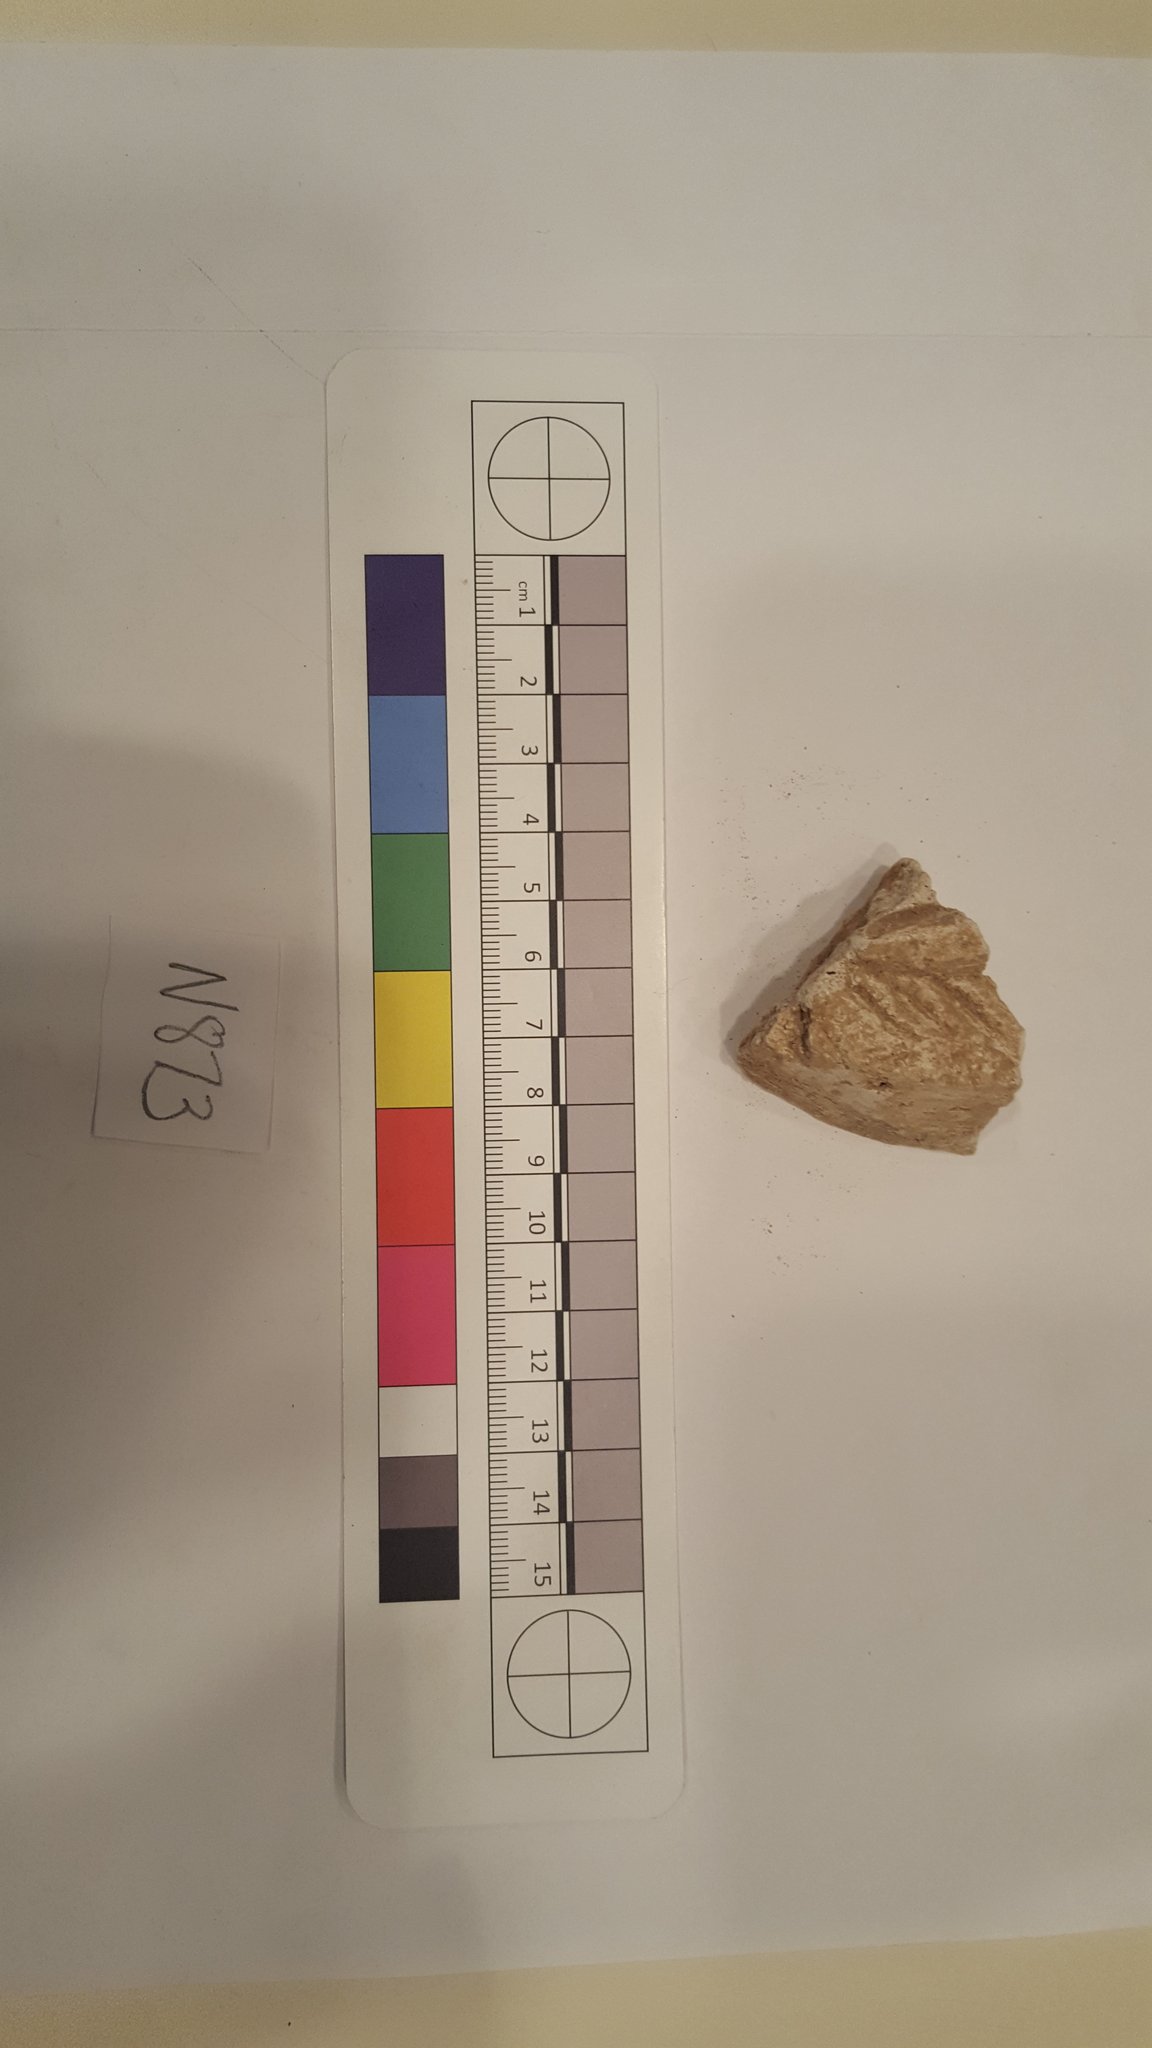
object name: fragment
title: Stucco Fragment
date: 701-1200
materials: plaster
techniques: carving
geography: iran